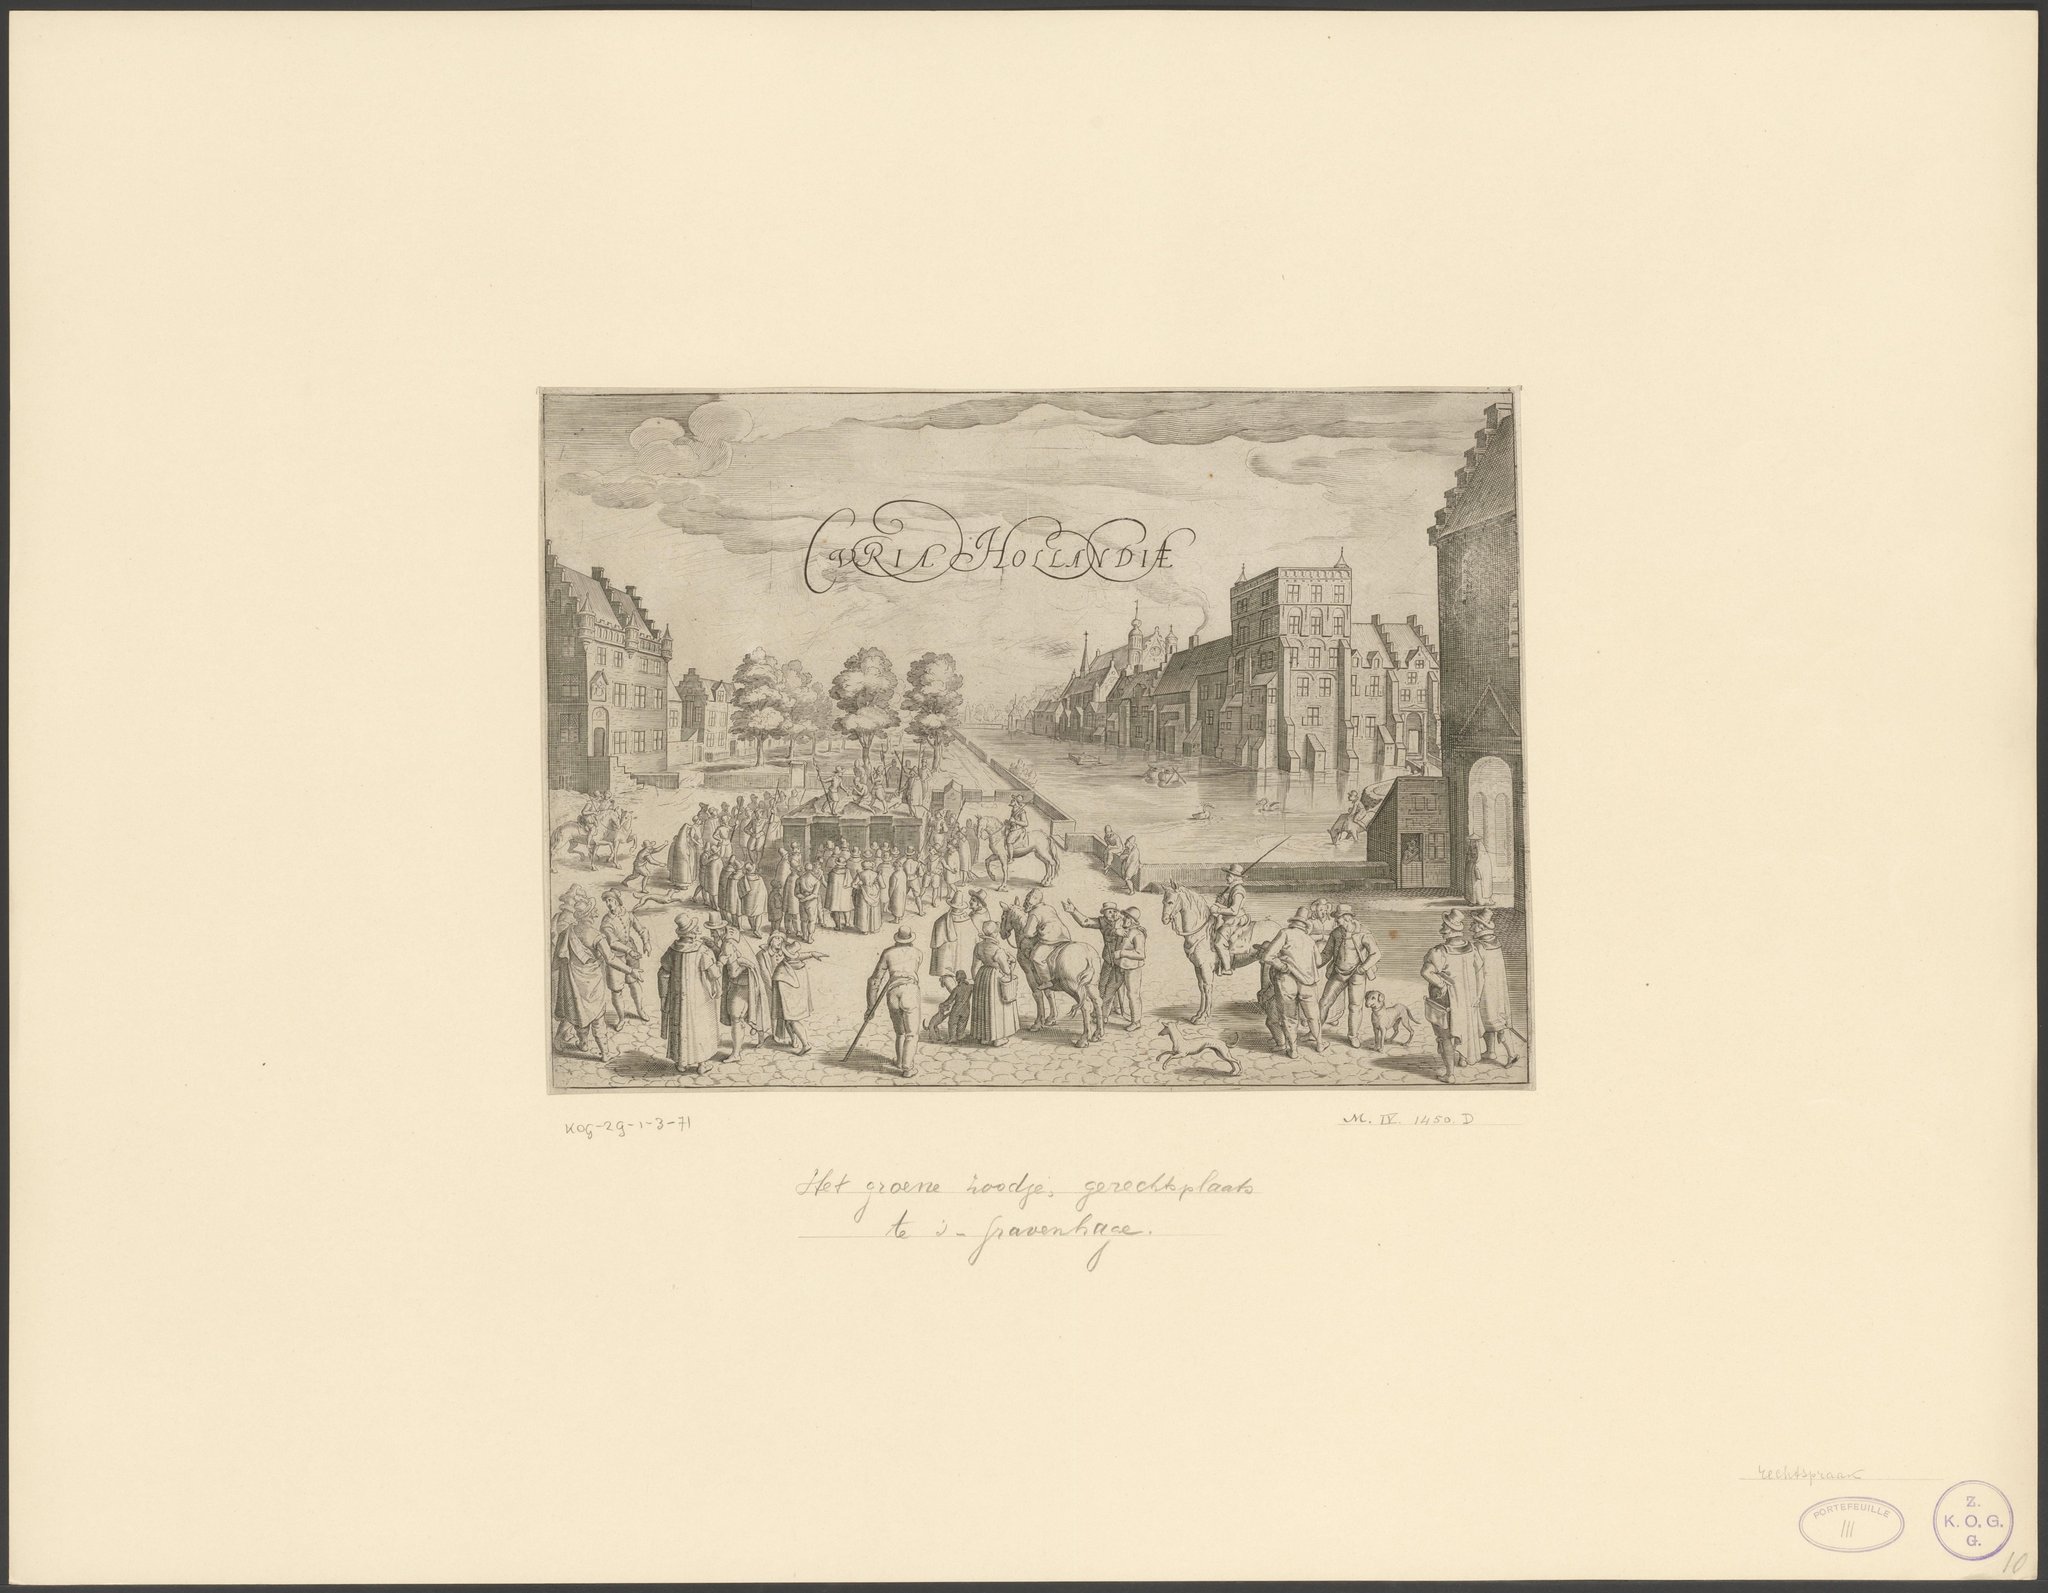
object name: book illustration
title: Hof van Holland, ca. 1610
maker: bartholomeus willemsz. dolendo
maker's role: print maker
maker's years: 1560-1626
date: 1610-1612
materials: paper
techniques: engraving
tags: on the scaffold or place of execution, violent death by beheading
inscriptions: stamp, collector's mark: Lugt 1641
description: Prent mogelijk uit: Orlers, Jan Jansz. Den Nassauschen Lauren-Crans: Beschrijvinghe ende af-beeldinge van alle de victorien (...). Leiden: Jan Jansz. Orlers en Henrick Lodewijcxsoon van Haestens, 1610, fol. 6/7. Of uit: Orlers, Jan Jansz. Les lauriers de Nassau: Description & representation de toutes les victoires(...). Leiden: Jan Jansz. Orlers en Henrick Lodewijcxsoon van Haestens, 1612, fol. 8/9.